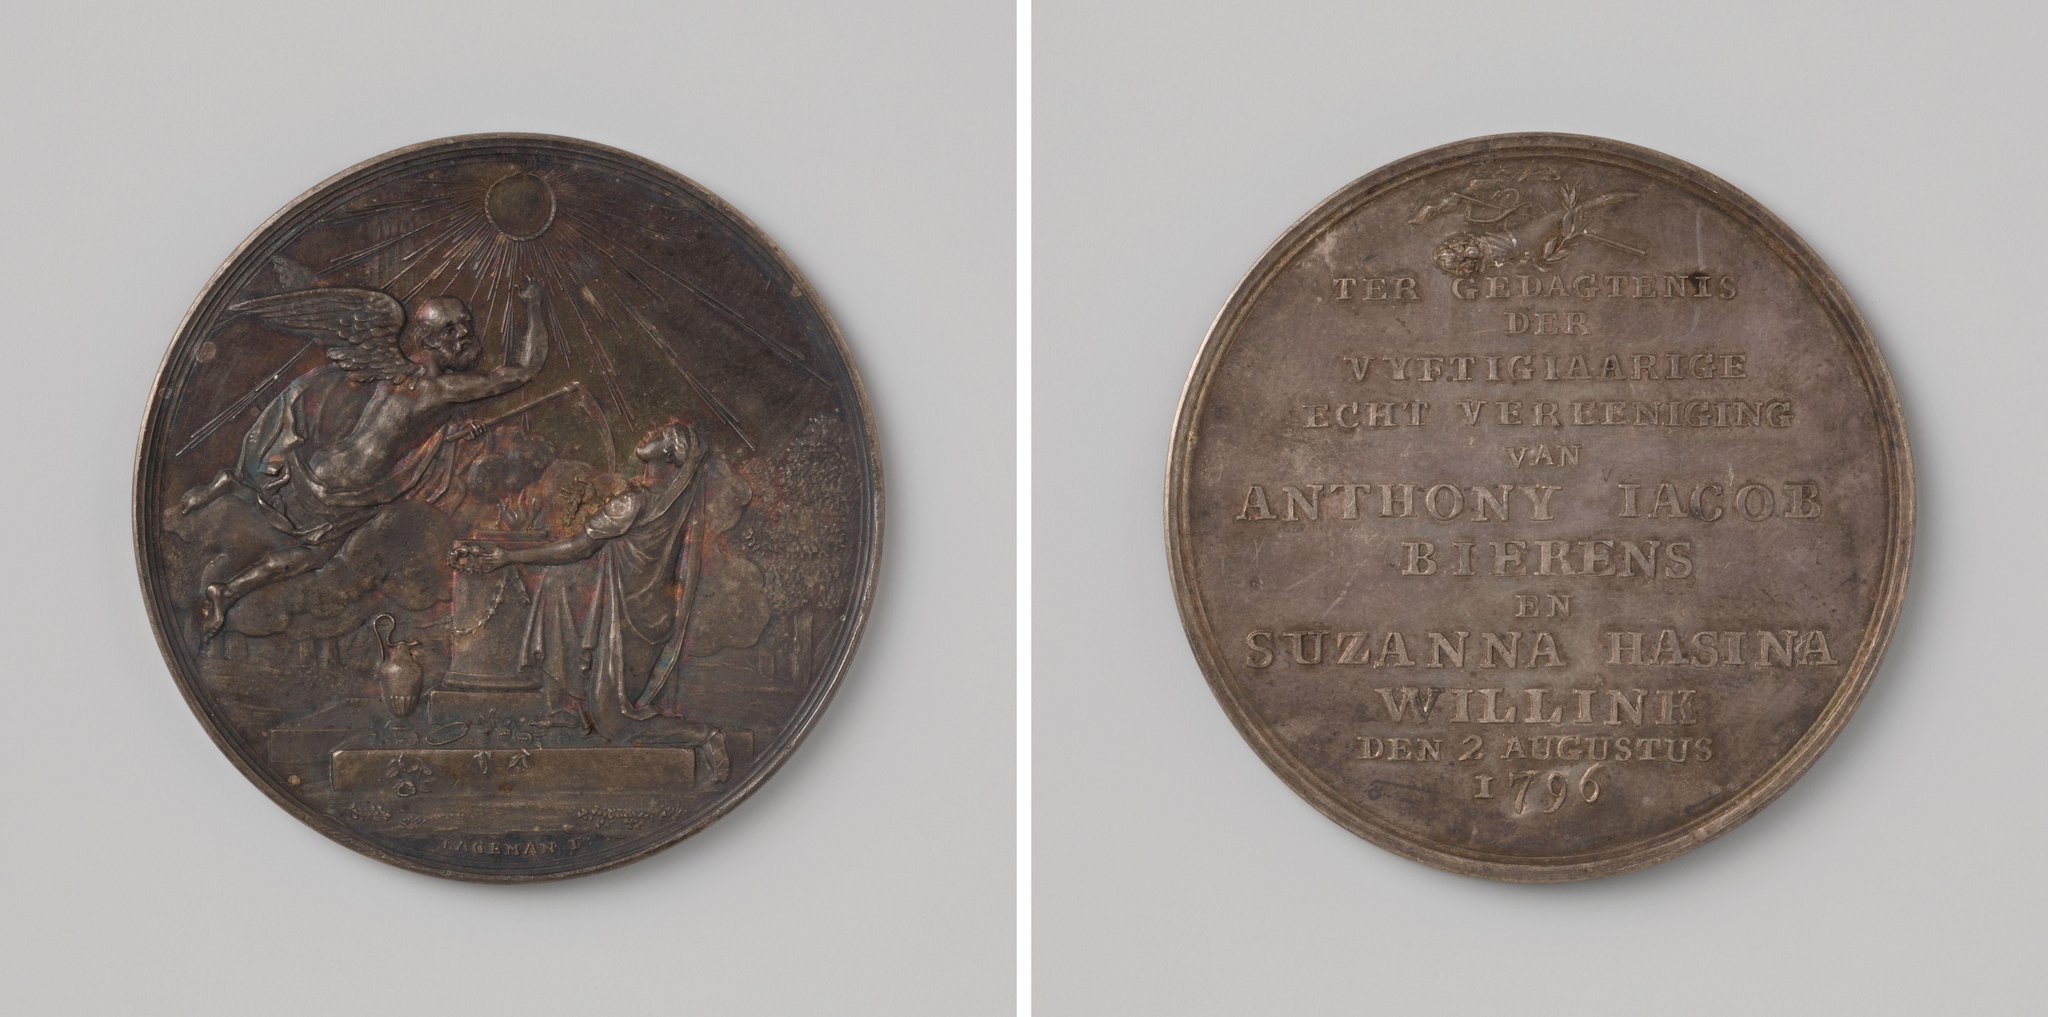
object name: family medal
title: Vijftigjarig huwelijk van Anthony Jacob Bierens en Suzanna Hasina Willink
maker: johannes michiel lageman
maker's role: silversmith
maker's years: 1735-1809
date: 1796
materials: silver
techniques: striking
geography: amsterdam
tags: amsterdam